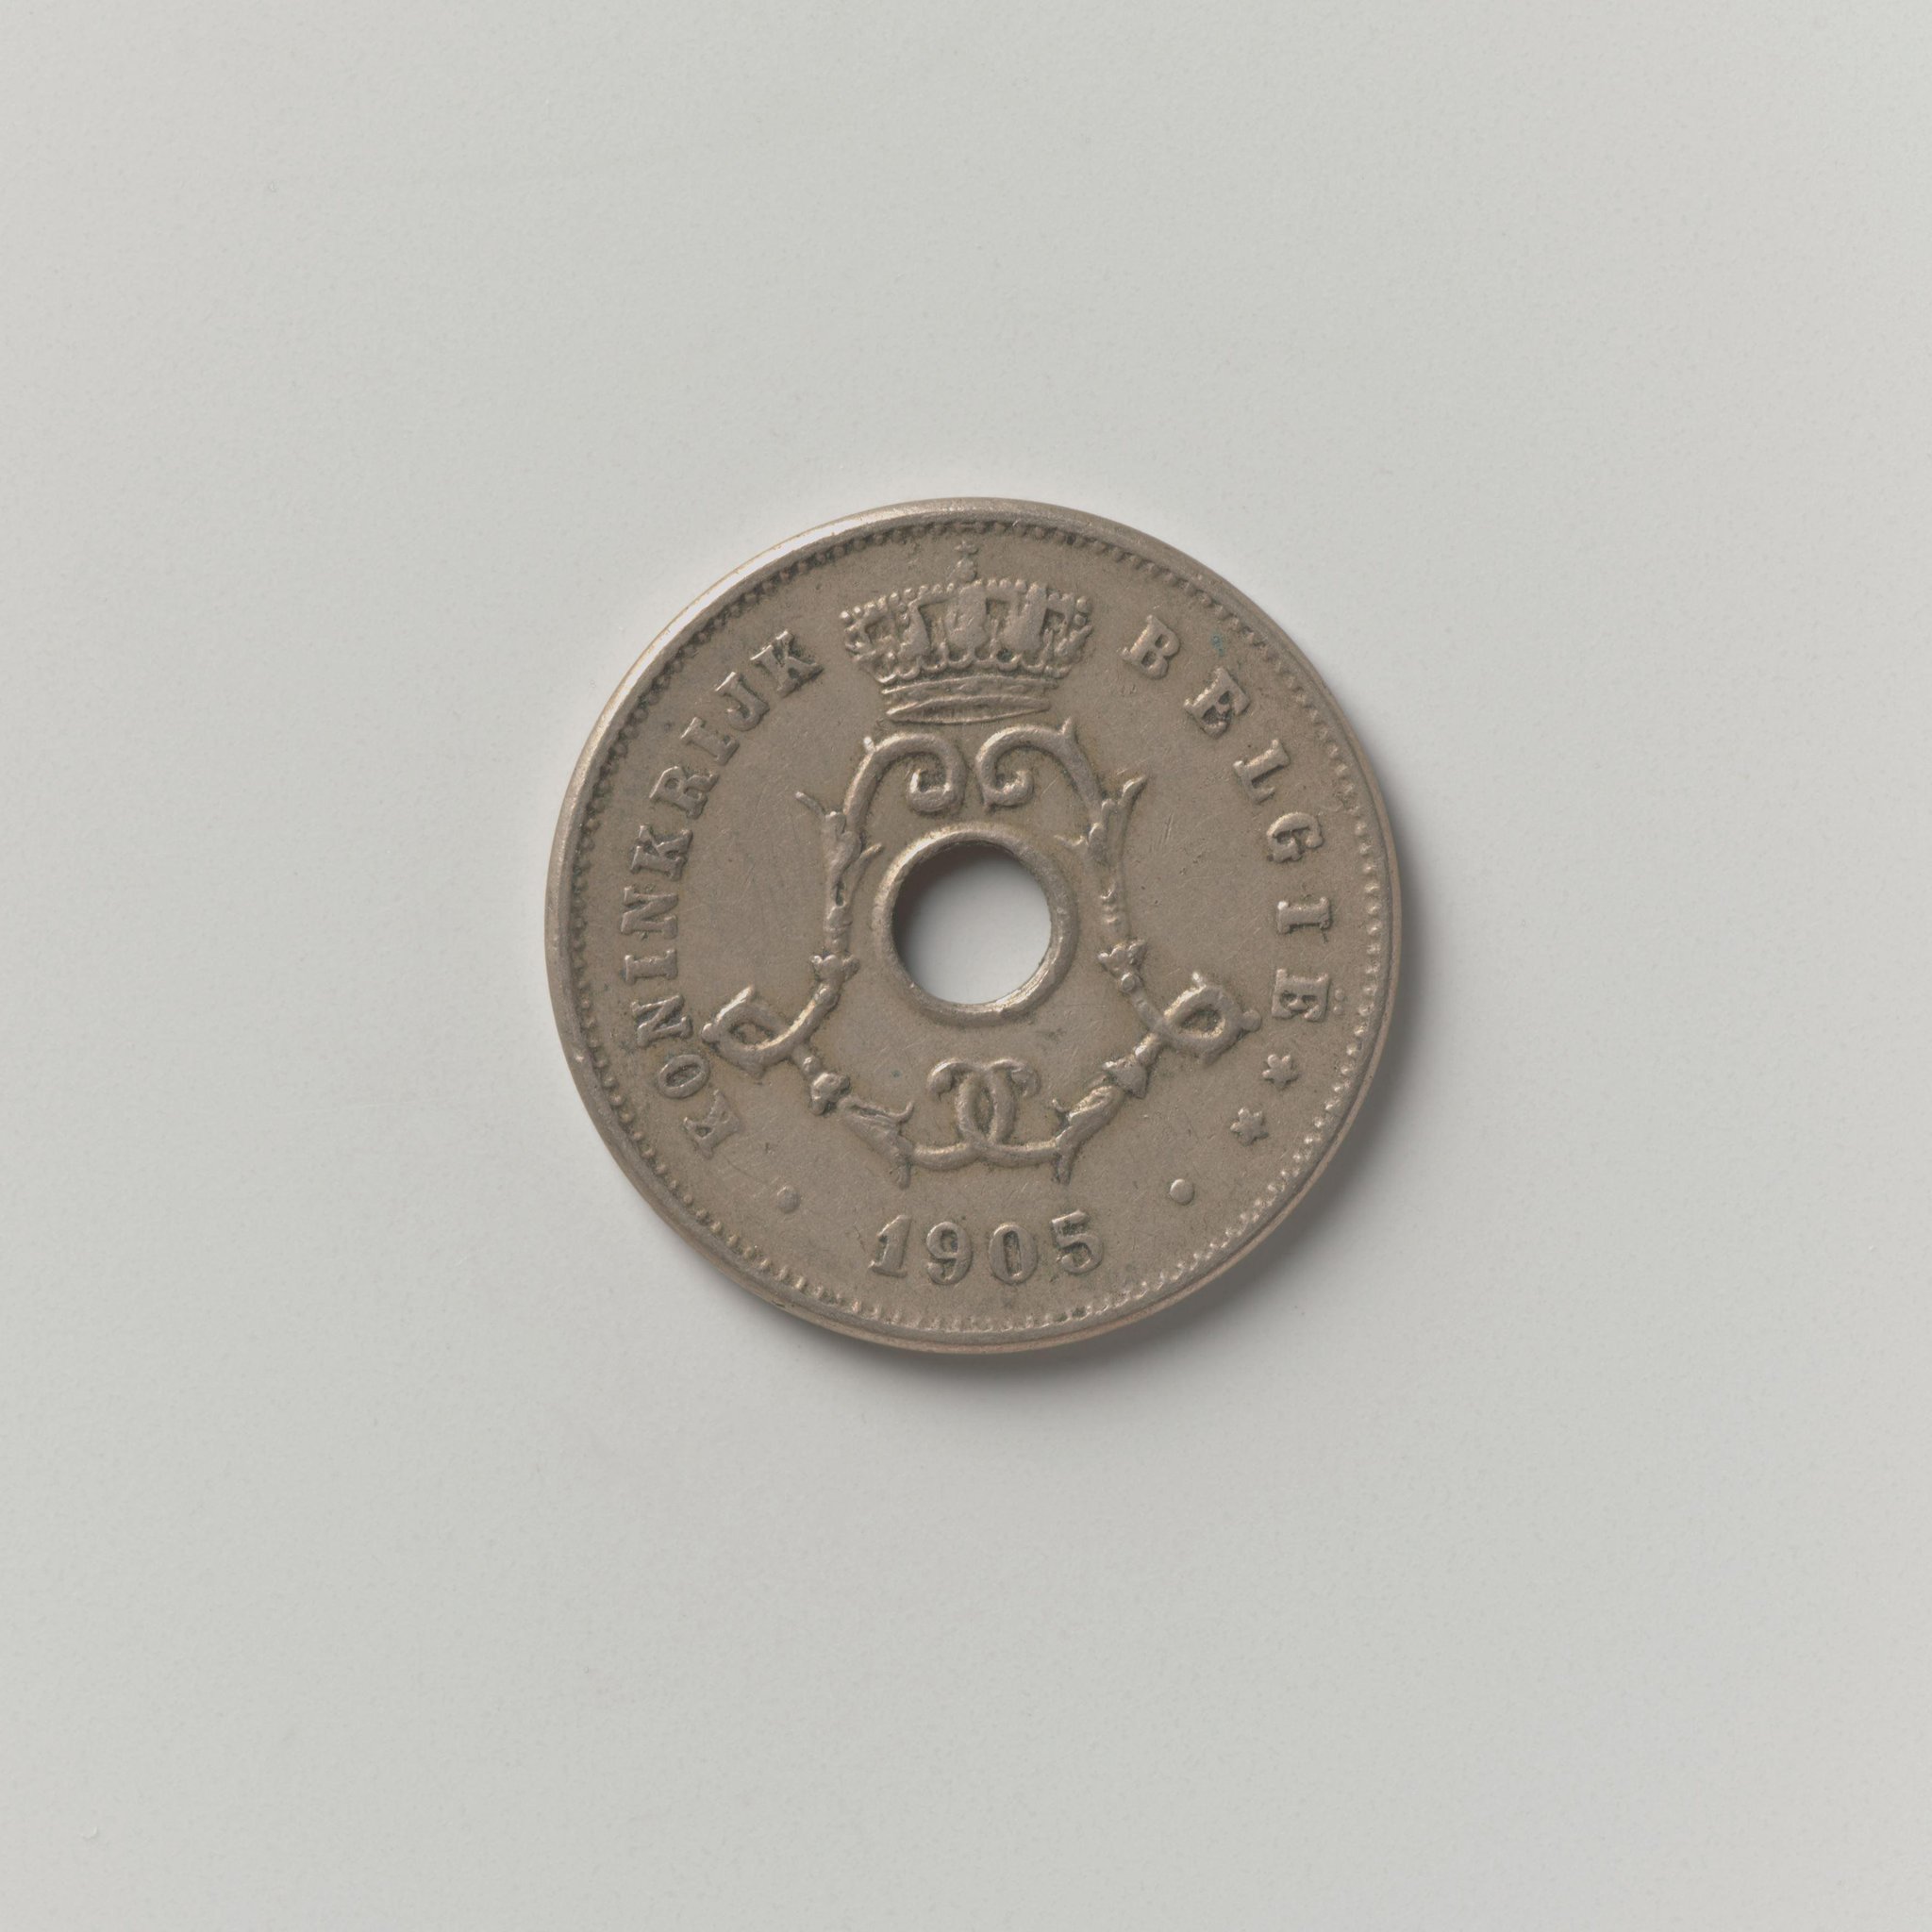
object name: coin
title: België, Leopold II, 5 centiemen, 1905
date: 1905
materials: nickel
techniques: striking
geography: brussels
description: Nikkelen munt. Voorzijde: gekroond monogram van twee letters L. Jaaartal onderaan. Keerzijde: rechts van gebogen lauwertak waarde-aanduiding 5 Cen. Centrale doorboring. Gladde rand.